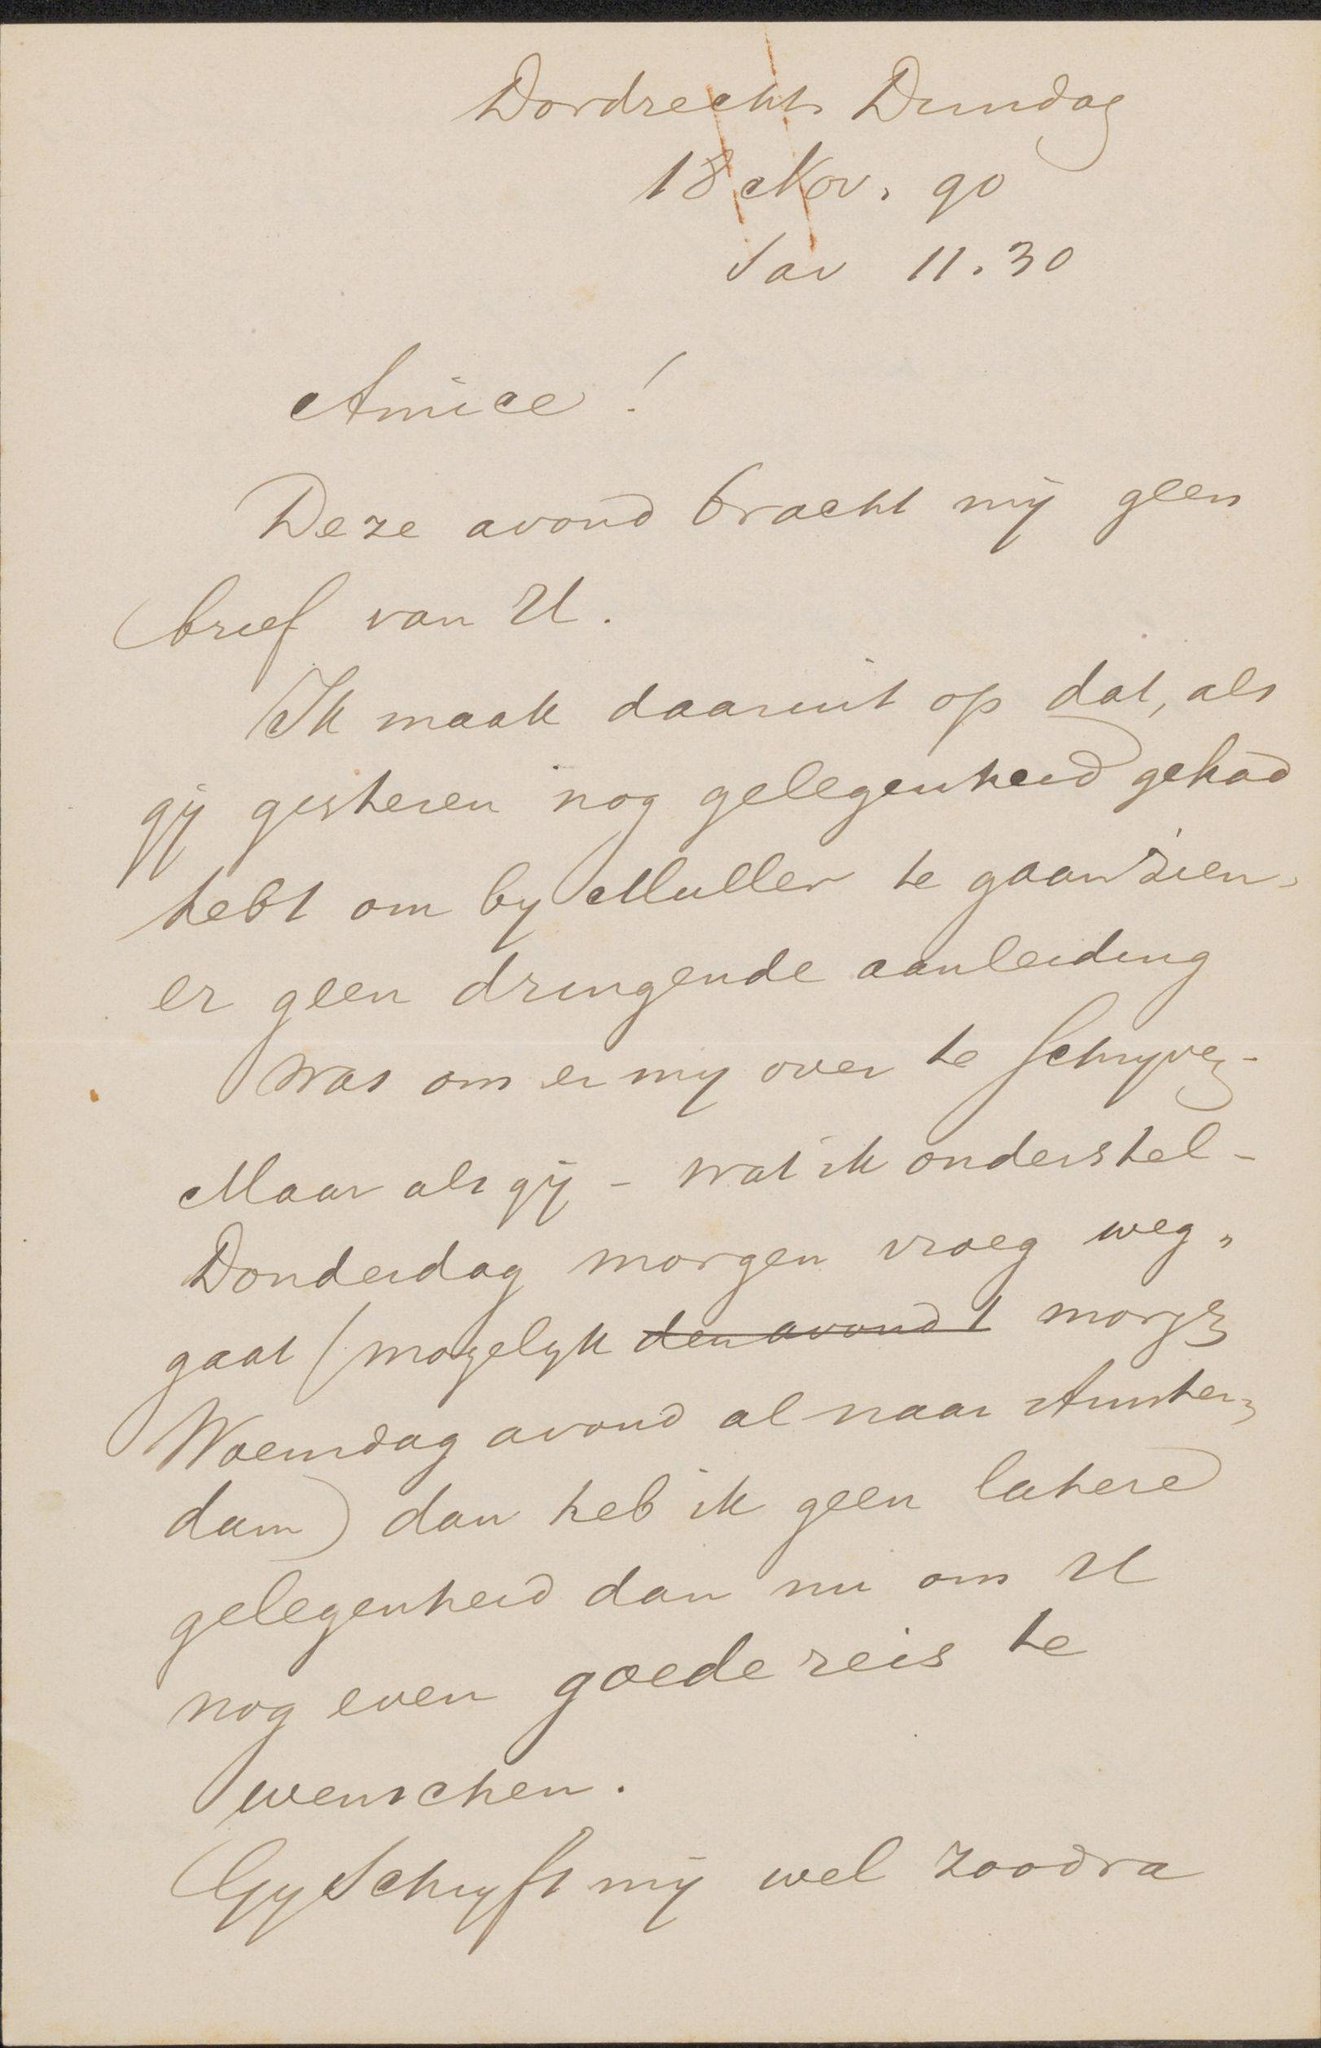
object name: letter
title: Brief aan Jan Veth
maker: martinus cornelis lebret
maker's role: verzamelaar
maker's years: 1833-1894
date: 1890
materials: ink, paper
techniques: pen, writing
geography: dordrecht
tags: amsterdam, painter, print maker, s. altmann, dordrecht, designer, jan veth, matthijs maris, draughtsman, jan voerman (1857-1941), albrecht dürer, the graphic arts, art collecting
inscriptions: collector's mark: ‘RPK’